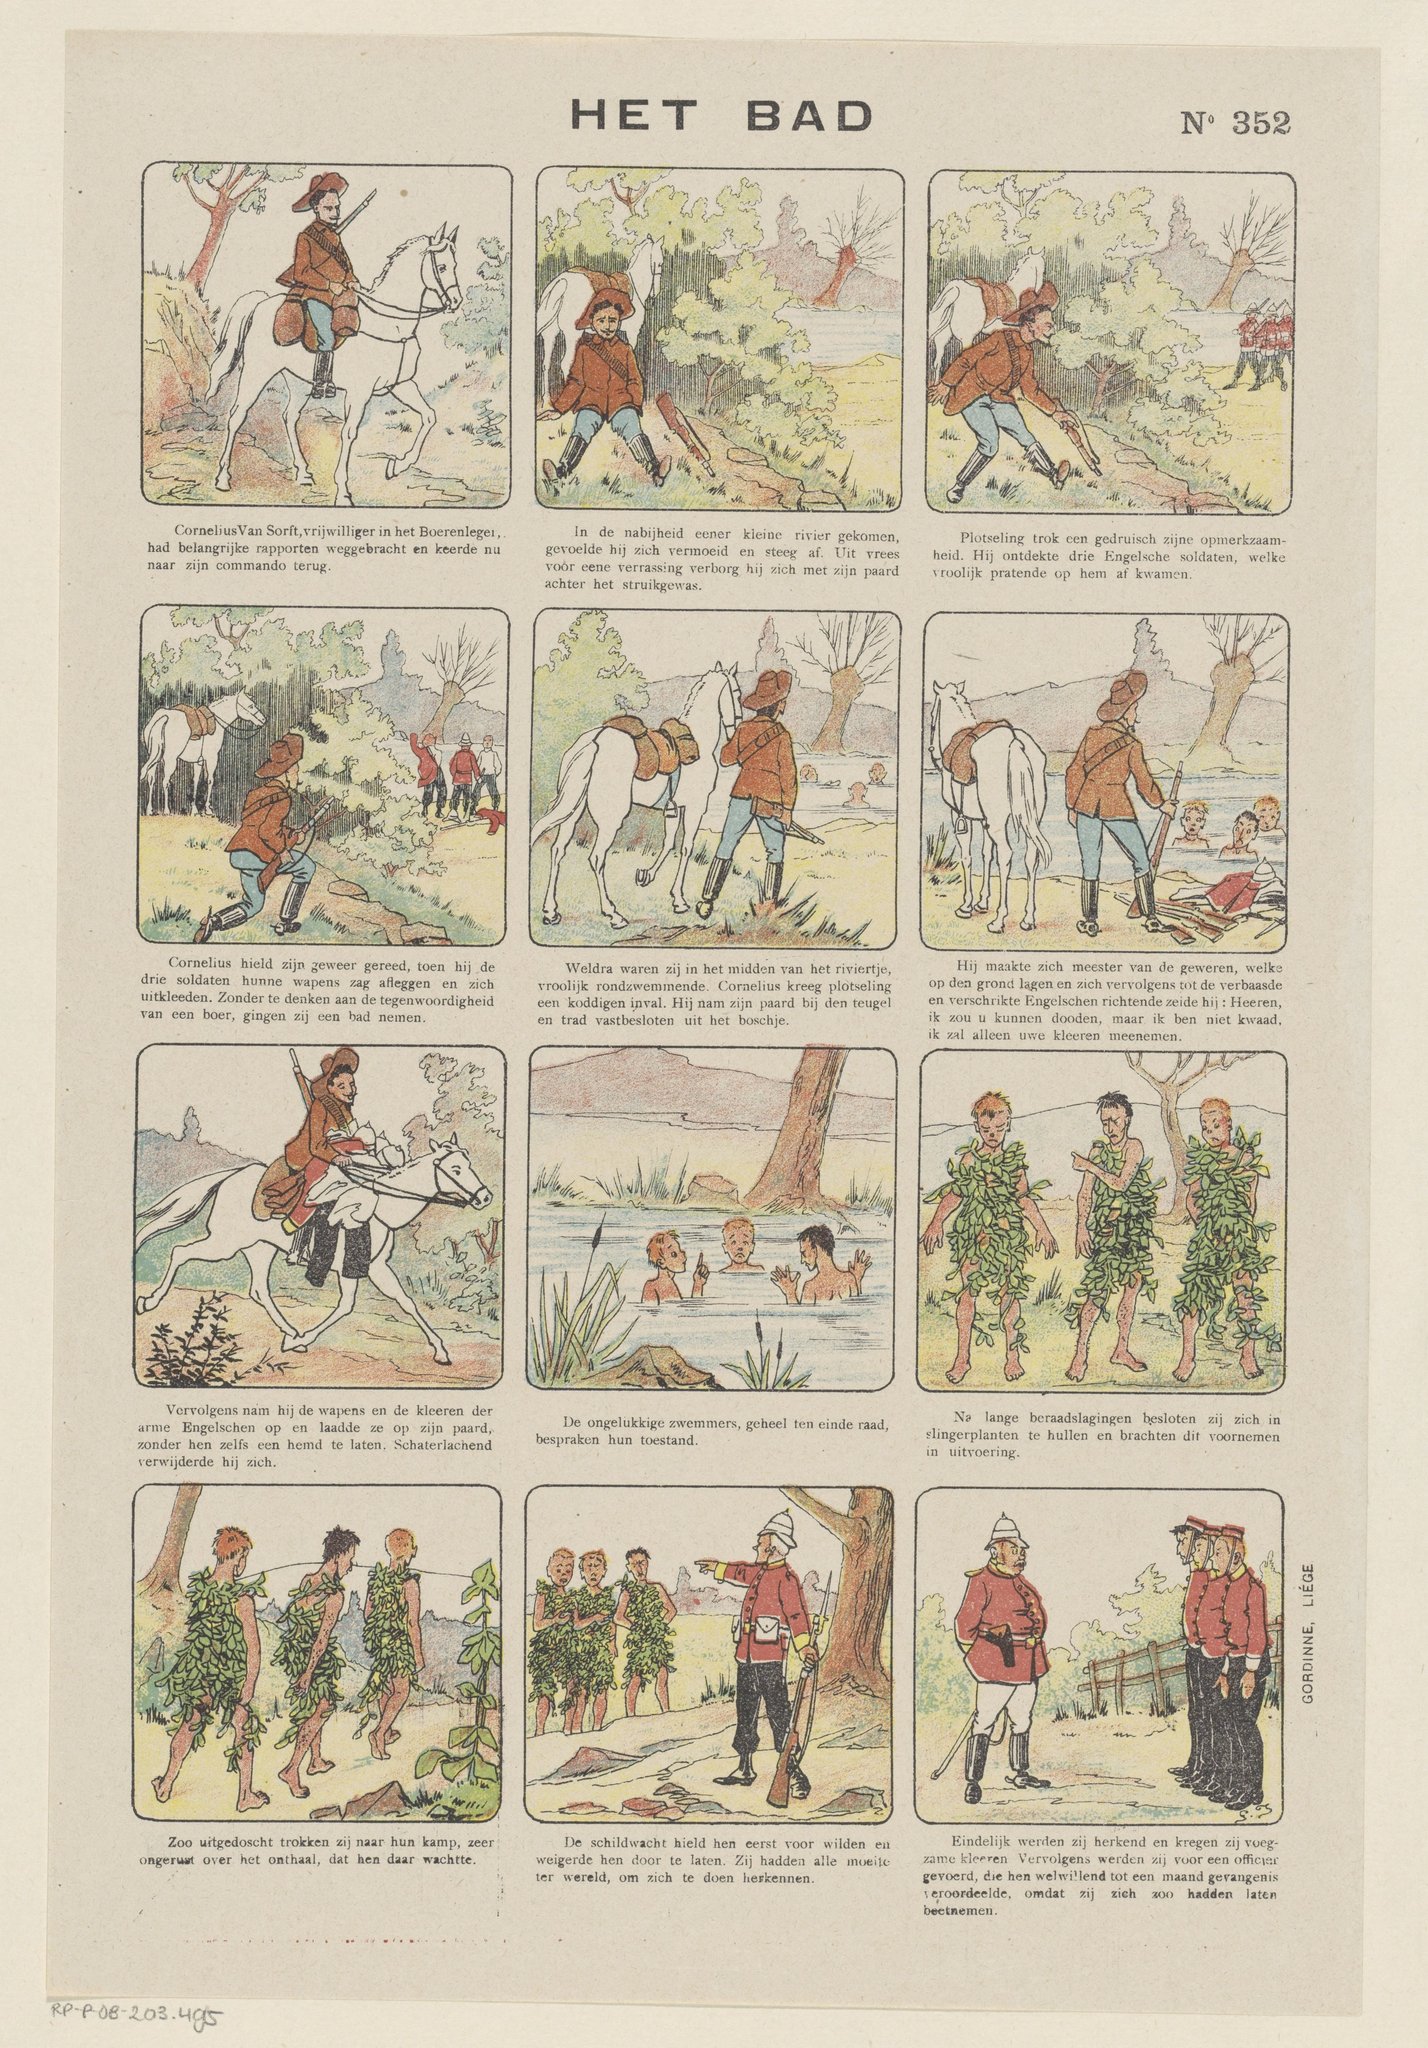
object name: print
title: Het bad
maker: monogrammist g.j.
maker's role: print maker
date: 1894-1959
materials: paper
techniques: lithograph, letterpress printing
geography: liège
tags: farmers, theft, the soldier; the soldier's life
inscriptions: collector's mark: Lugt 2760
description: Blad met 12 voorstellingen over de boerensoldaat Cornelius van Sorf die de kleren en wapens van drie zwemmende Engelse soldaten steelt. Onder elke afbeelding een onderschrift. Genummerd rechtsboven: No 352.